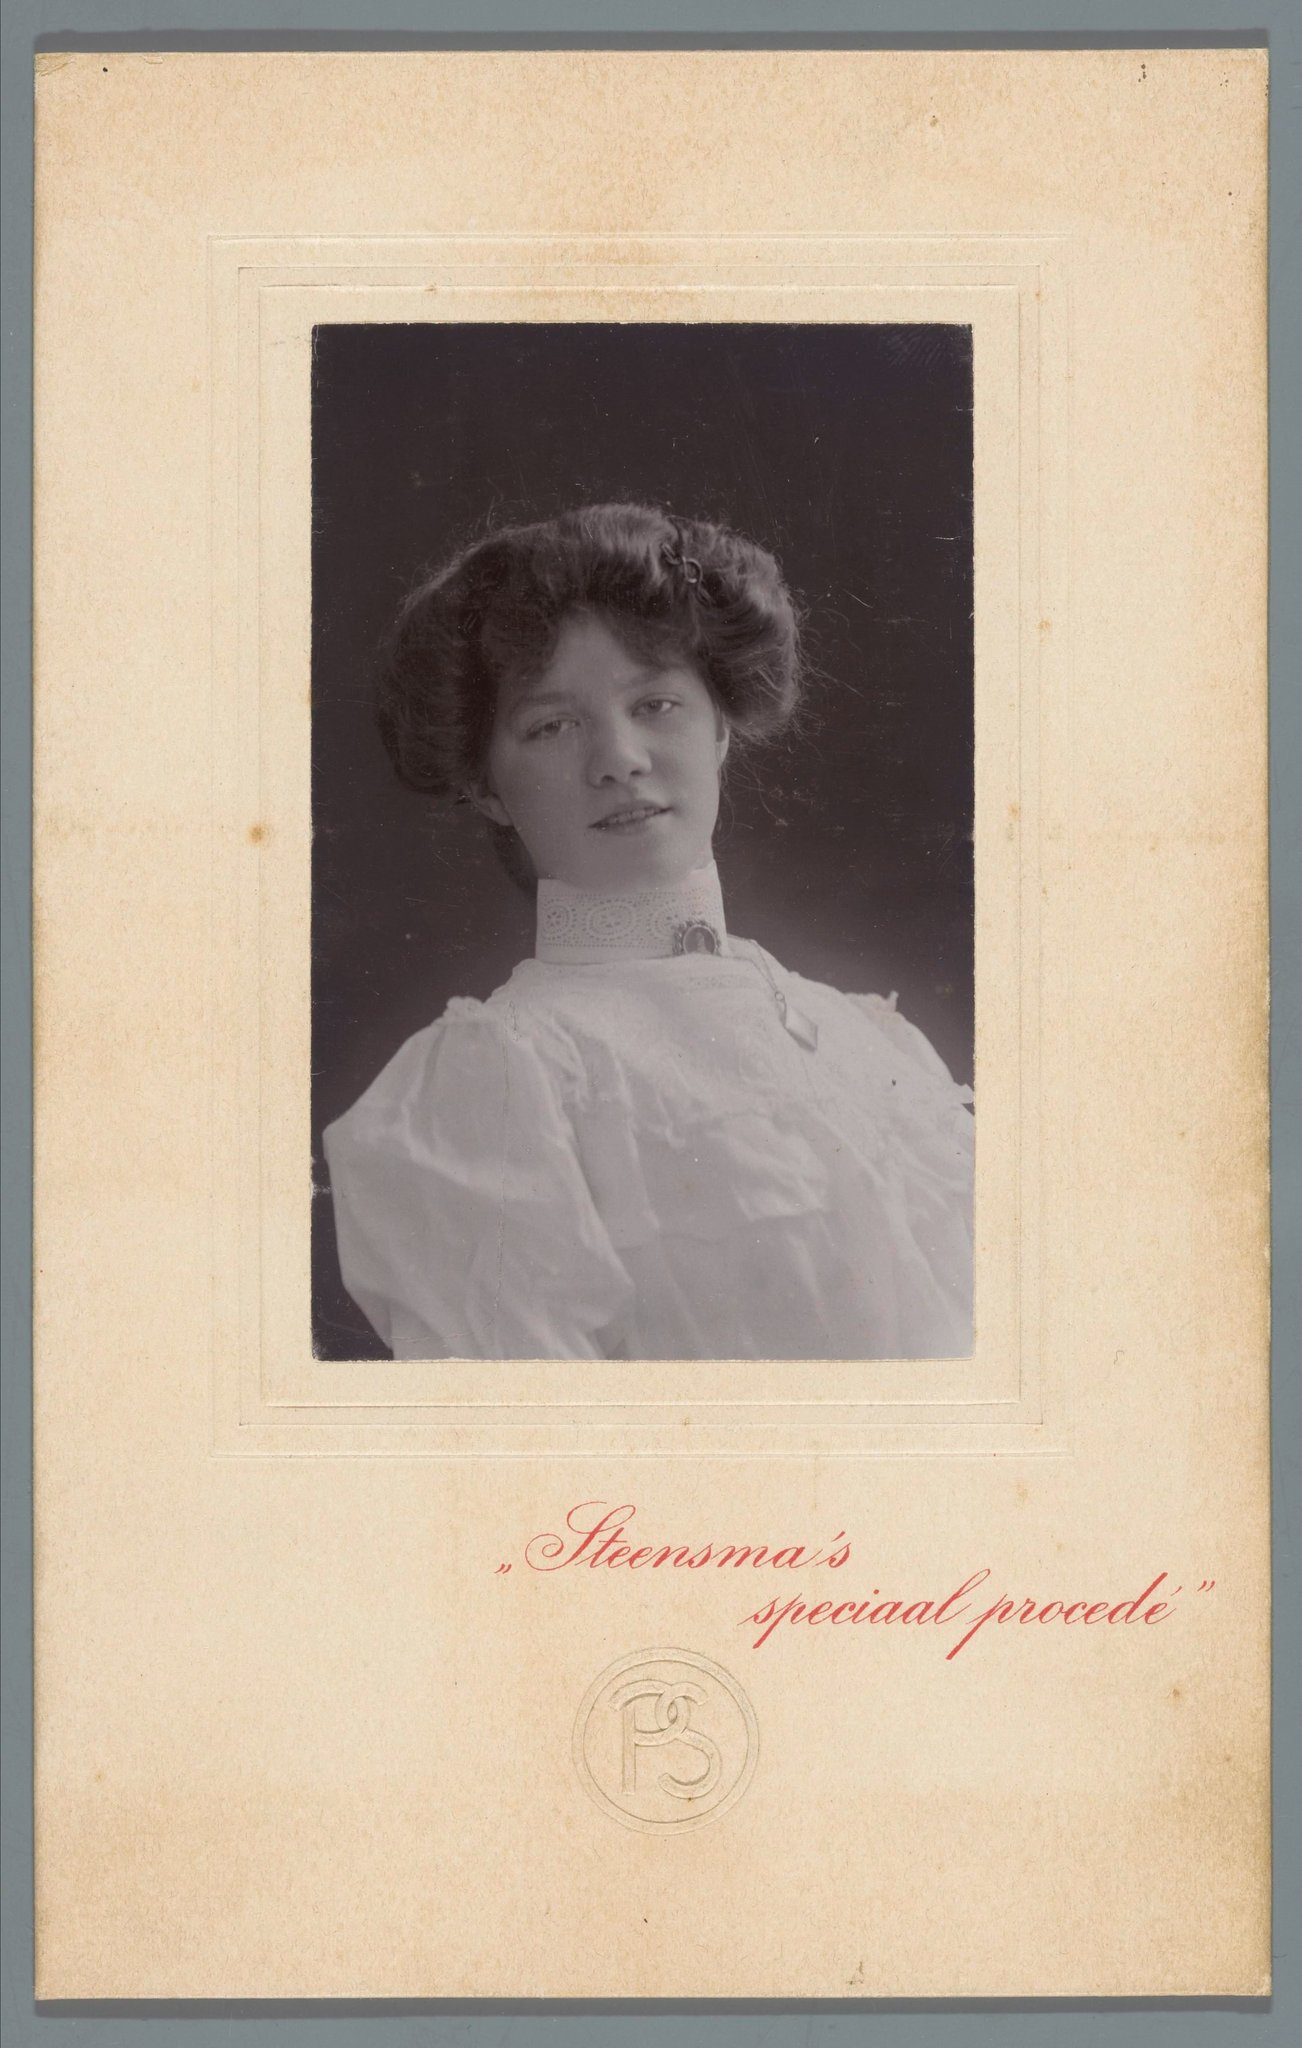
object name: photograph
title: Portret van een onbekende vrouw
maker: pier steensma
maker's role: fotograaf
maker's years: 1879-1931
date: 1910-1920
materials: cardboard, photographic support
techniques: collodion silver print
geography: amsterdam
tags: adult woman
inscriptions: inscription: ‘Houdbaarheid en afwerking van dit procedé worden alleen gewaarborgd indien het is vervaardigd door P. Steensma, fotograaf Heerenstraat 6, bij de Heerengracht Amsterdam’